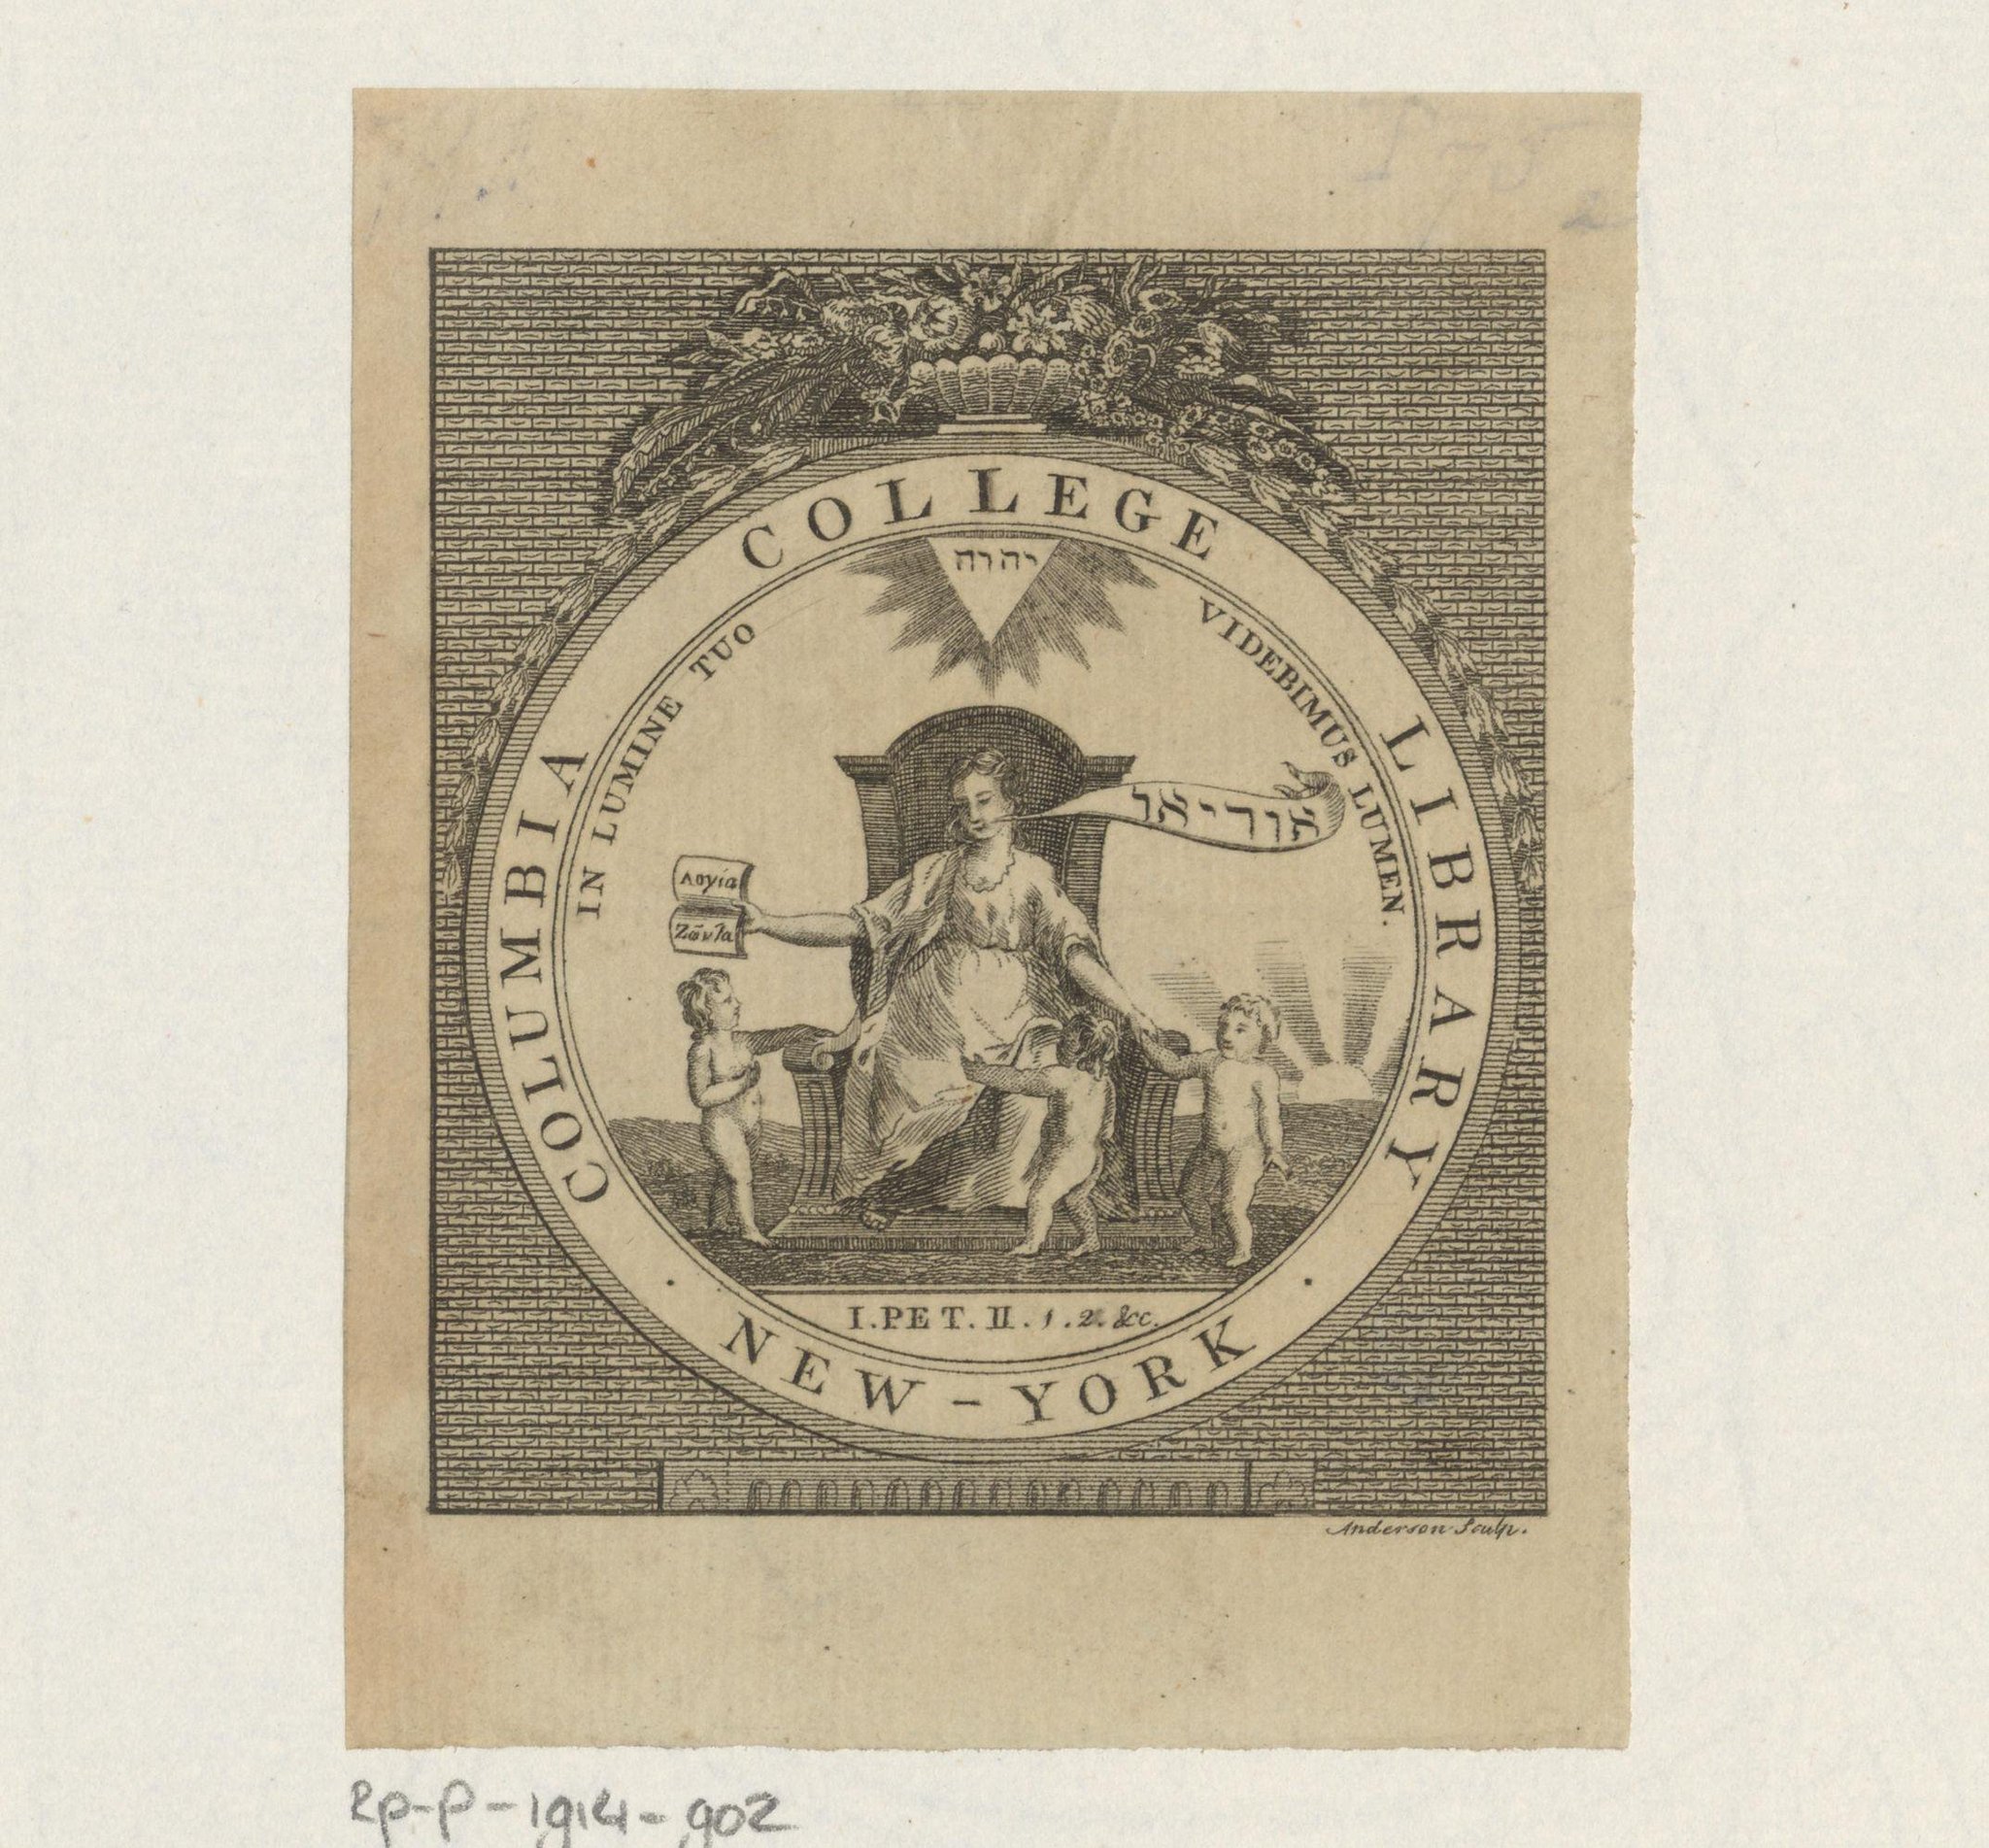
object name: bookplate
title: Ex libris van Columbia College Library, New York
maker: anderson (prentmaker)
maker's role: print maker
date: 1754-1849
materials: paper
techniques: engraving, etching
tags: library, hebrew script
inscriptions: collector's mark: Lugt 2233, collector's mark: Lugt 2760